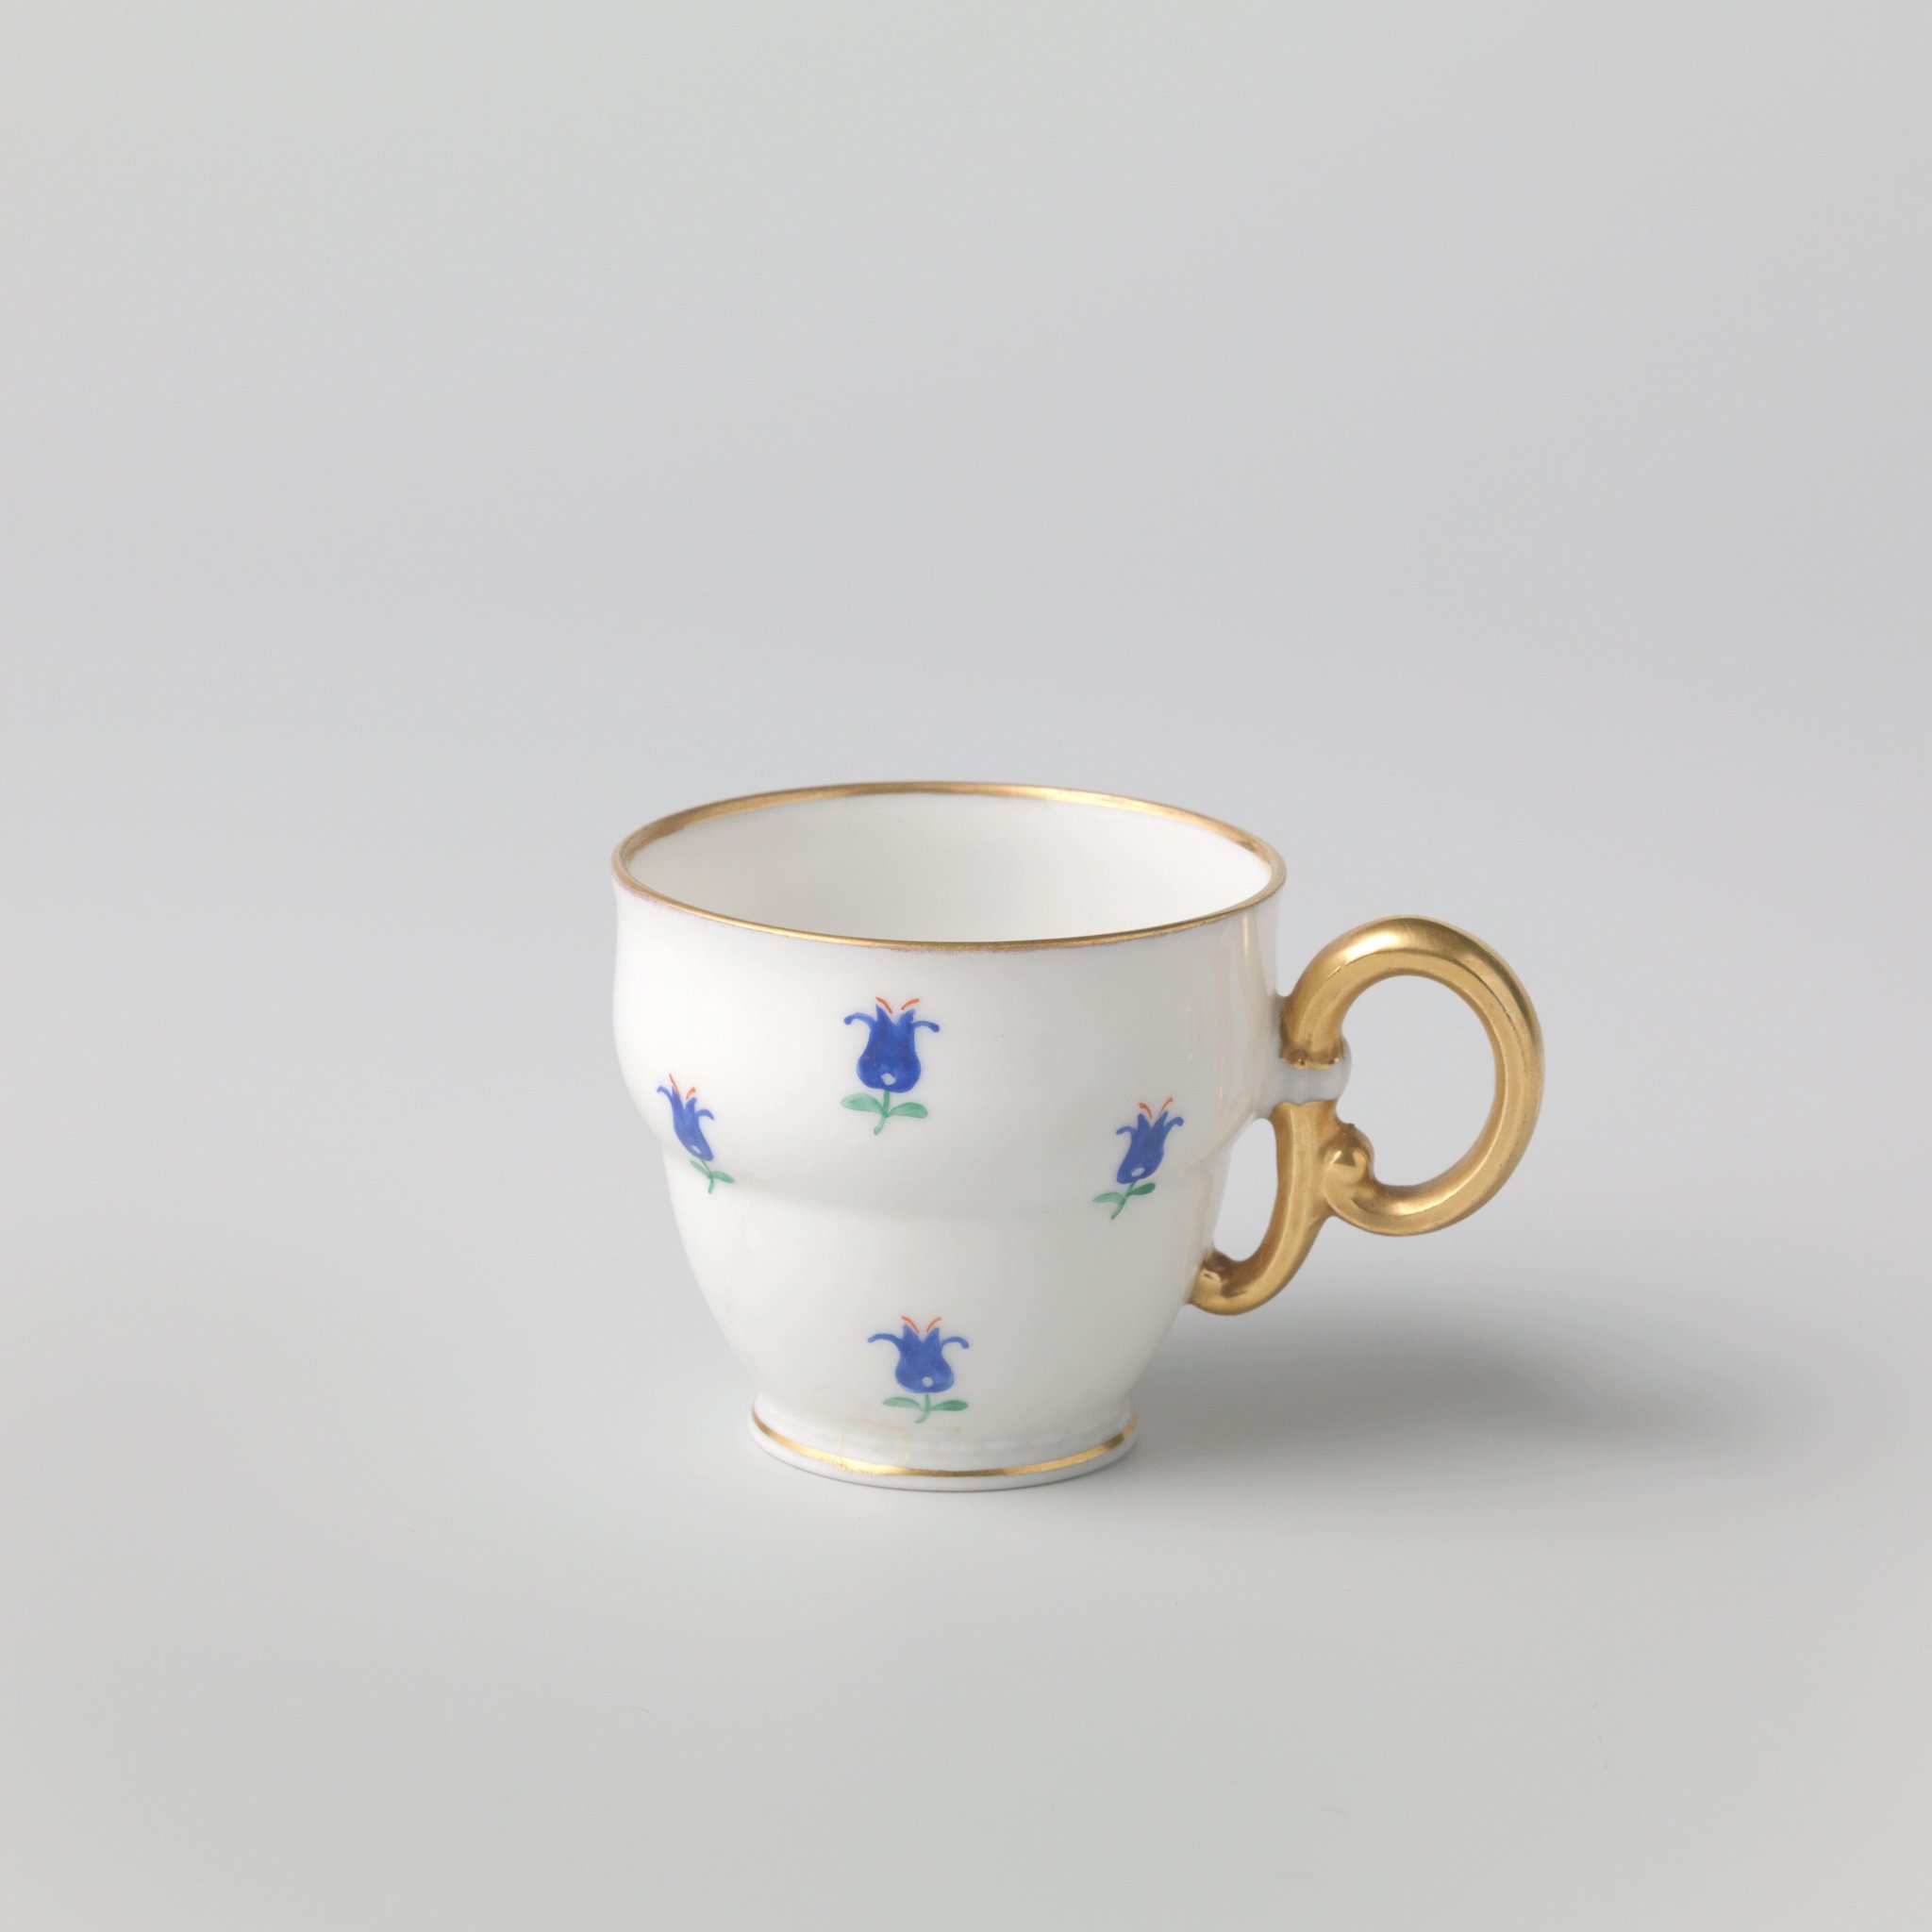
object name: coffee service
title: Cup bowl with flowers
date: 1935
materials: glaze, gold, paint, porcelain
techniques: firing, forming, gilding, turning, vitrification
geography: karlovy vary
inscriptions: mark: ‘gekruiste hamers met kroon/ EPIAG PIRKENHAMMER CECHOSLOW/ 5857’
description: Kop van porselein op iets spreidende voet met een licht uitlopende wand die net boven de helft verdikt, P-vormige oor. Beschilderd op het glazuur in blauw, rood, groen en goud. De buitenwand met blauwe bloemen en een gouden oor. Gouden lijn op de voet en de rand. Gemerkt op de onderzijde met de gekruiste hamers met kroon, de tekst 'EPIAG PIRKENHAMMER CECHOSLOW' en het nummer 5857.